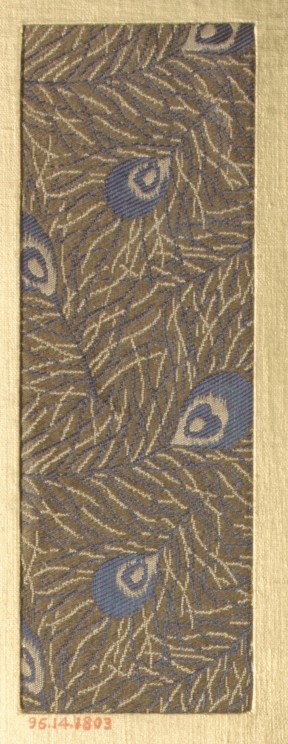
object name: piece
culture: japanese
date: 1701-1900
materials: silk